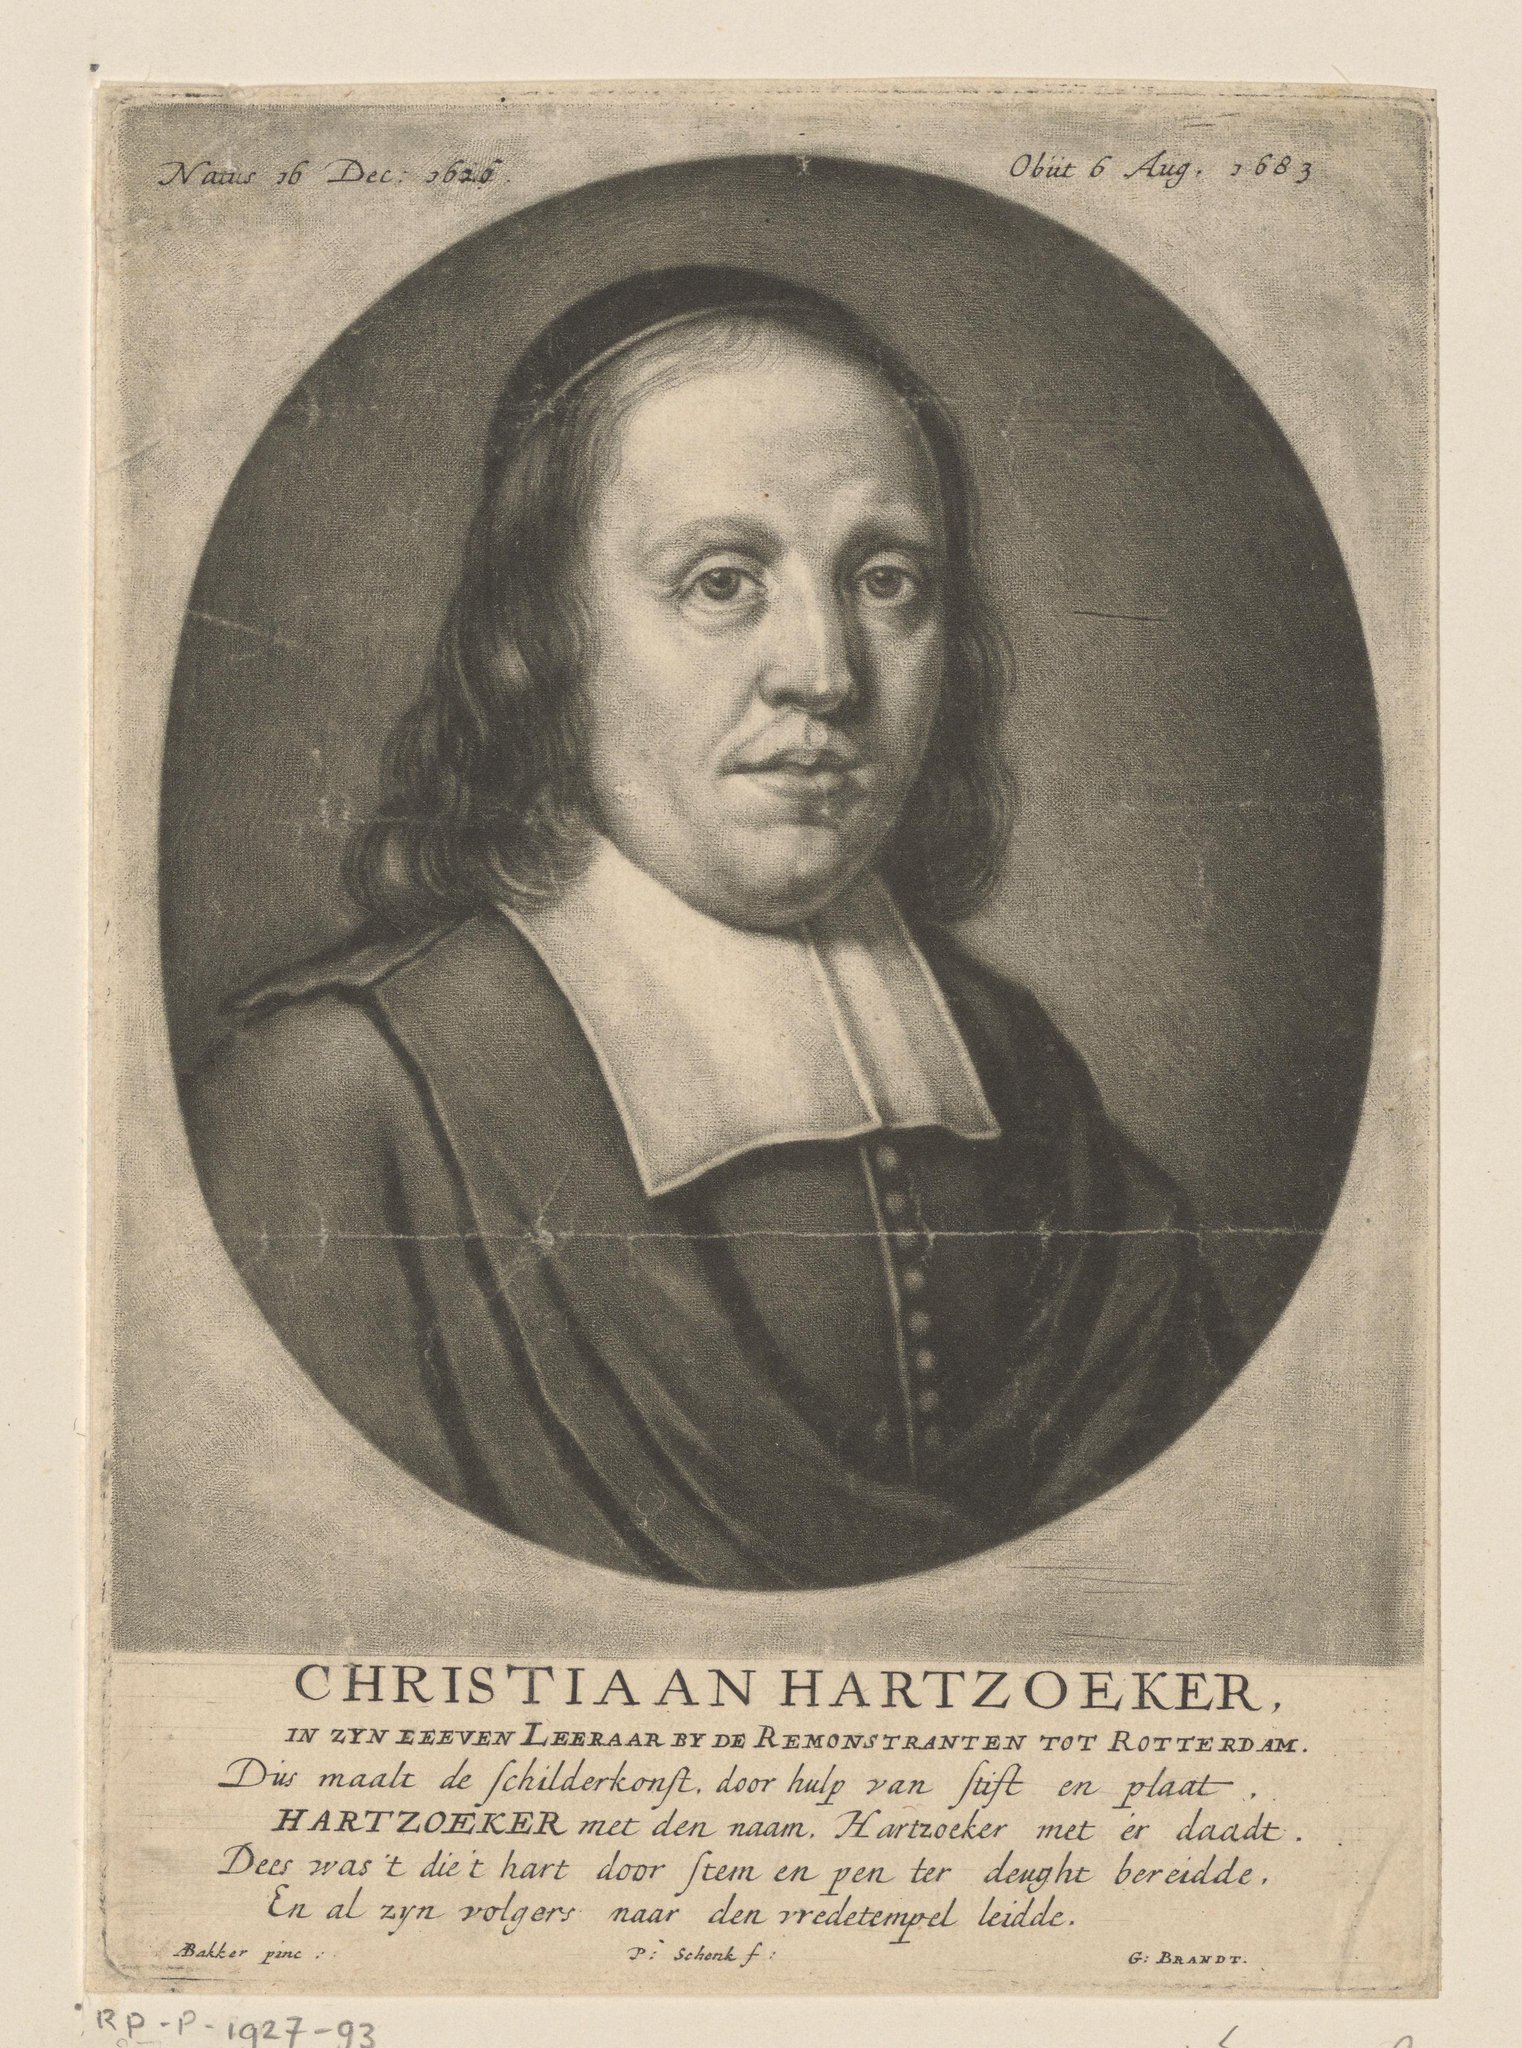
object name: print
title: Portret van Christiaan Hartsoecker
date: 1683-1713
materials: paper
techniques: engraving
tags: historical persons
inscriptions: collector's mark: Lugt 2166